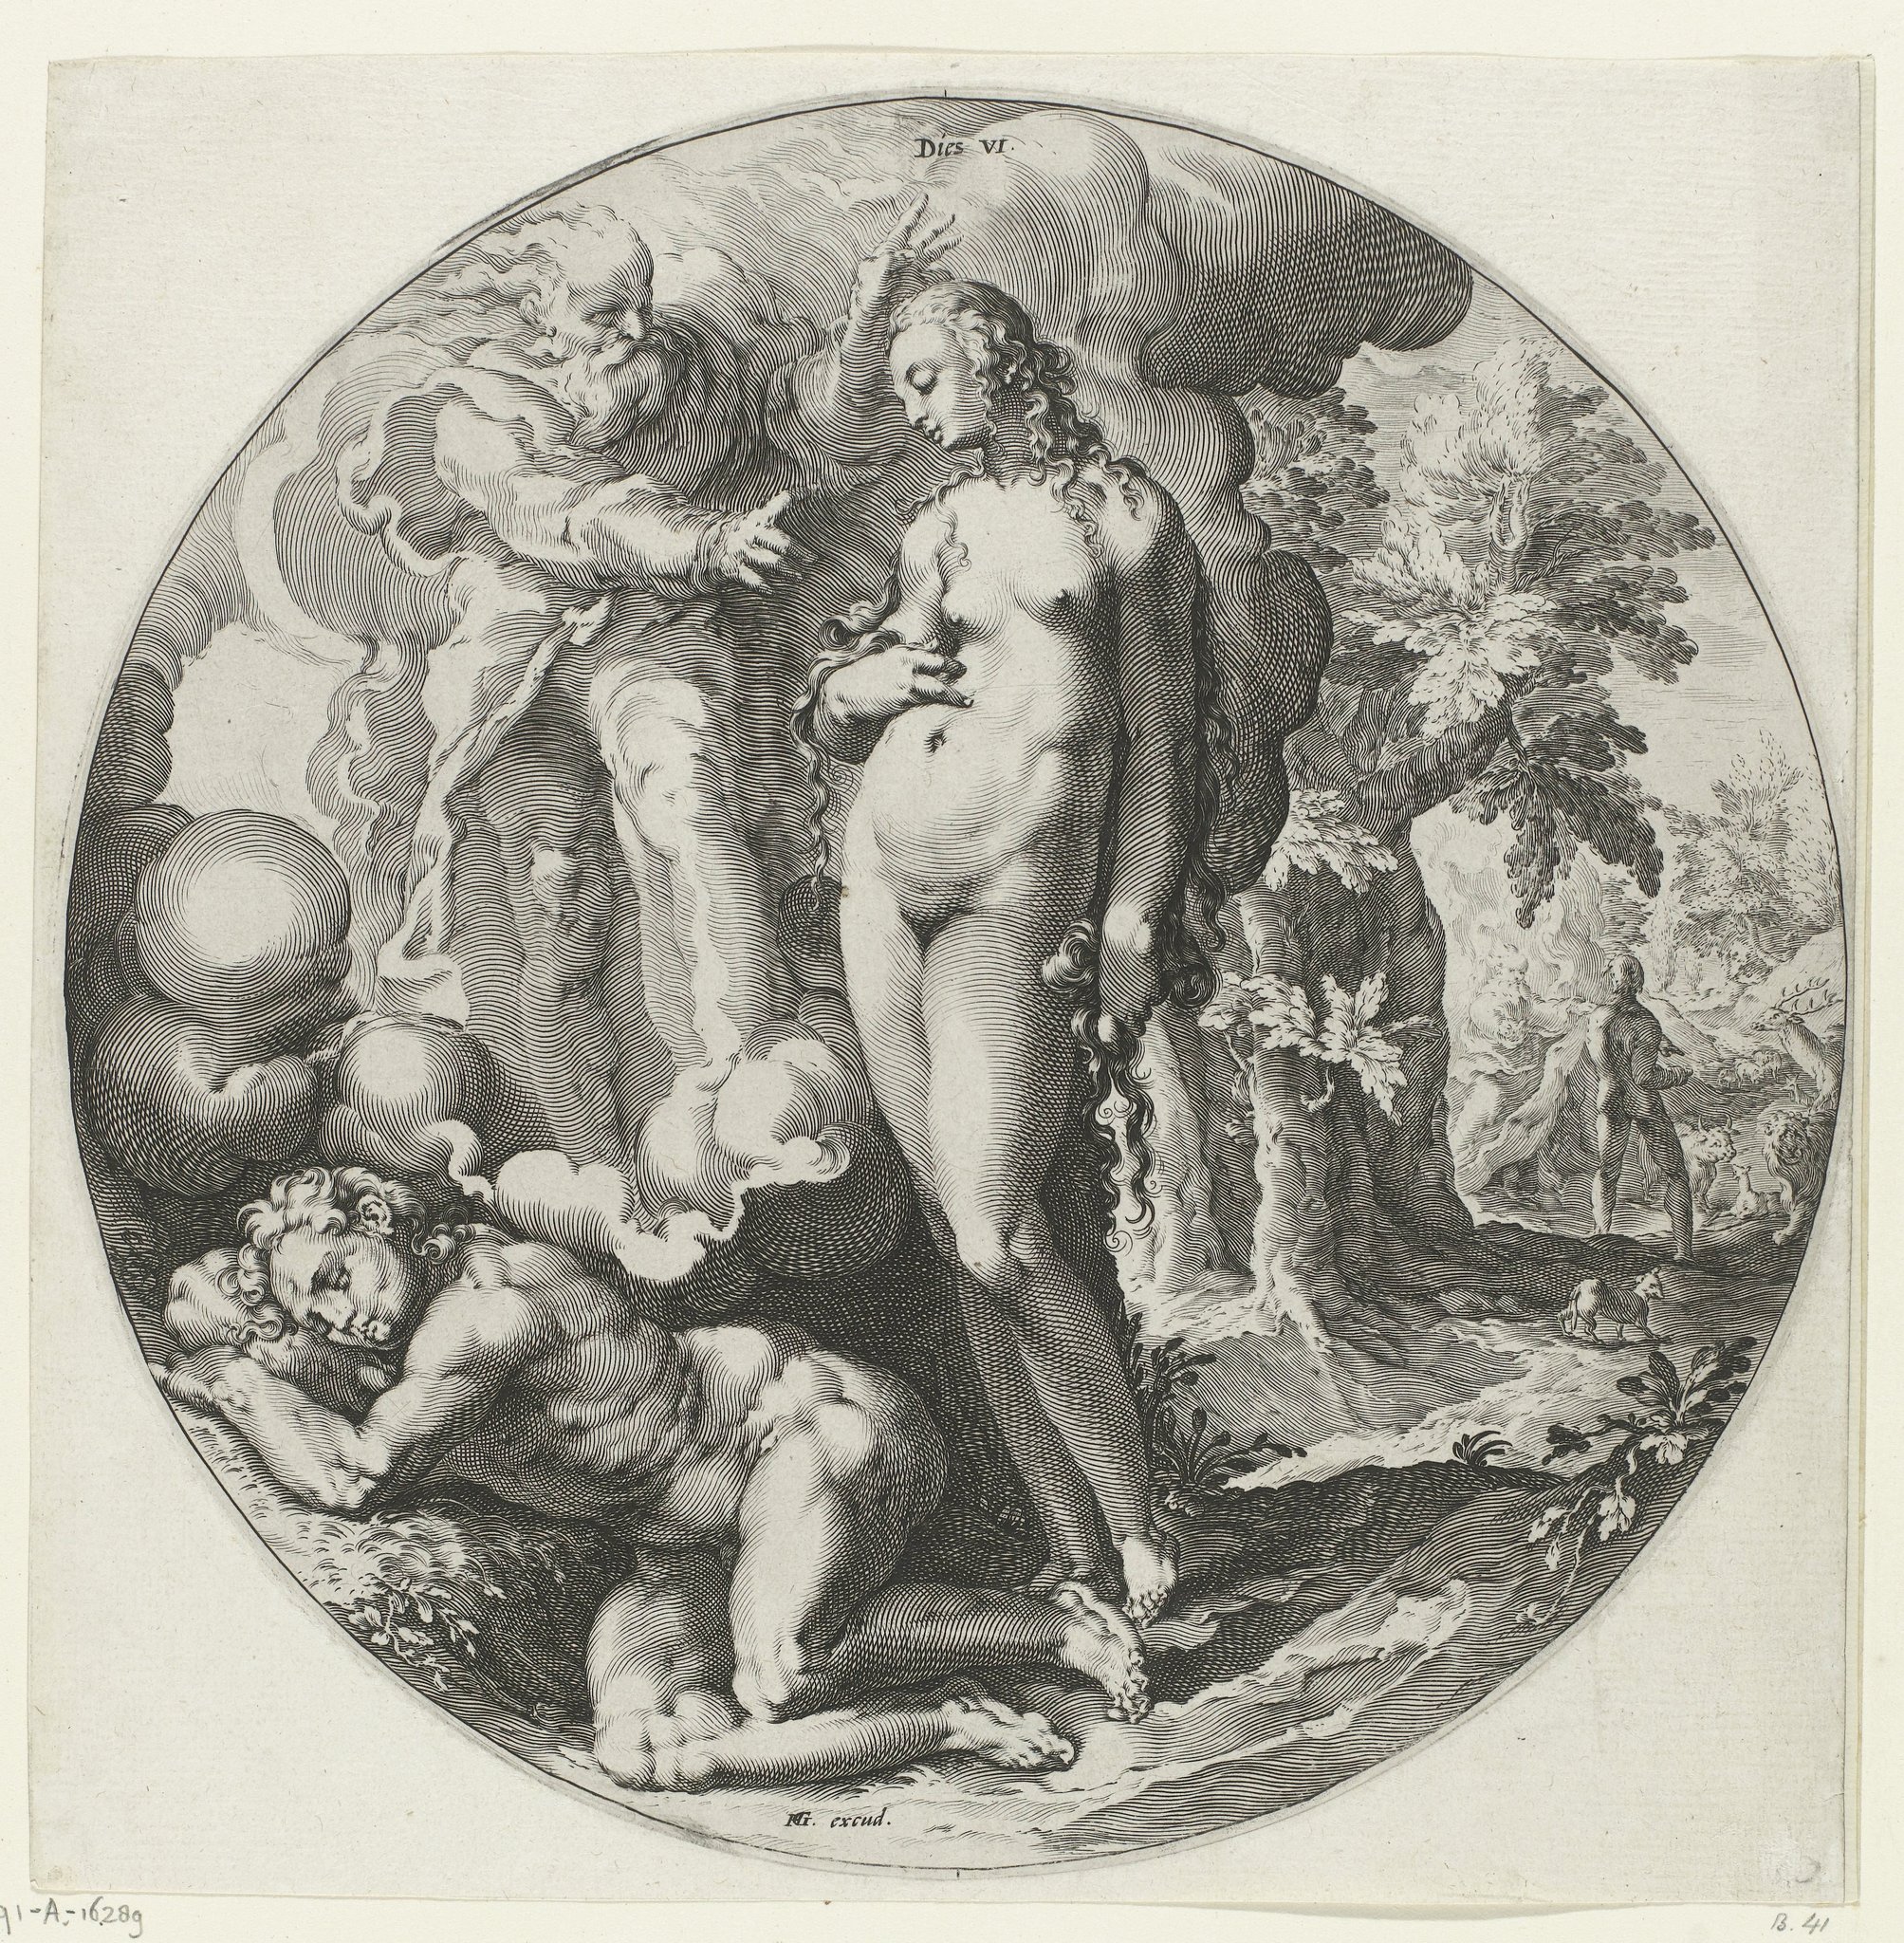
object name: print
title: Schepping van de wereld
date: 1589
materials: paper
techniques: engraving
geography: haarlem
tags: creation of man; the garden of eden (genesis 1:26 - 2)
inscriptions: collector's mark: Lugt 2228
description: De zesde scheppingsdag: God schept Eva, terwijl Adam op de grond ligt te slapen. Op de achtergrond God de Vader en Adam. Adam wijst op de dieren. Naar de Bijbeltekst in Gen. 1:26-31.